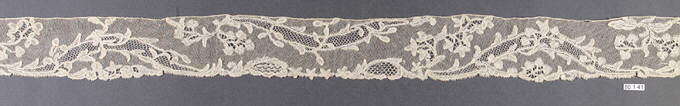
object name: piece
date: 1701-1800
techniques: lace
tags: flowers,leaves